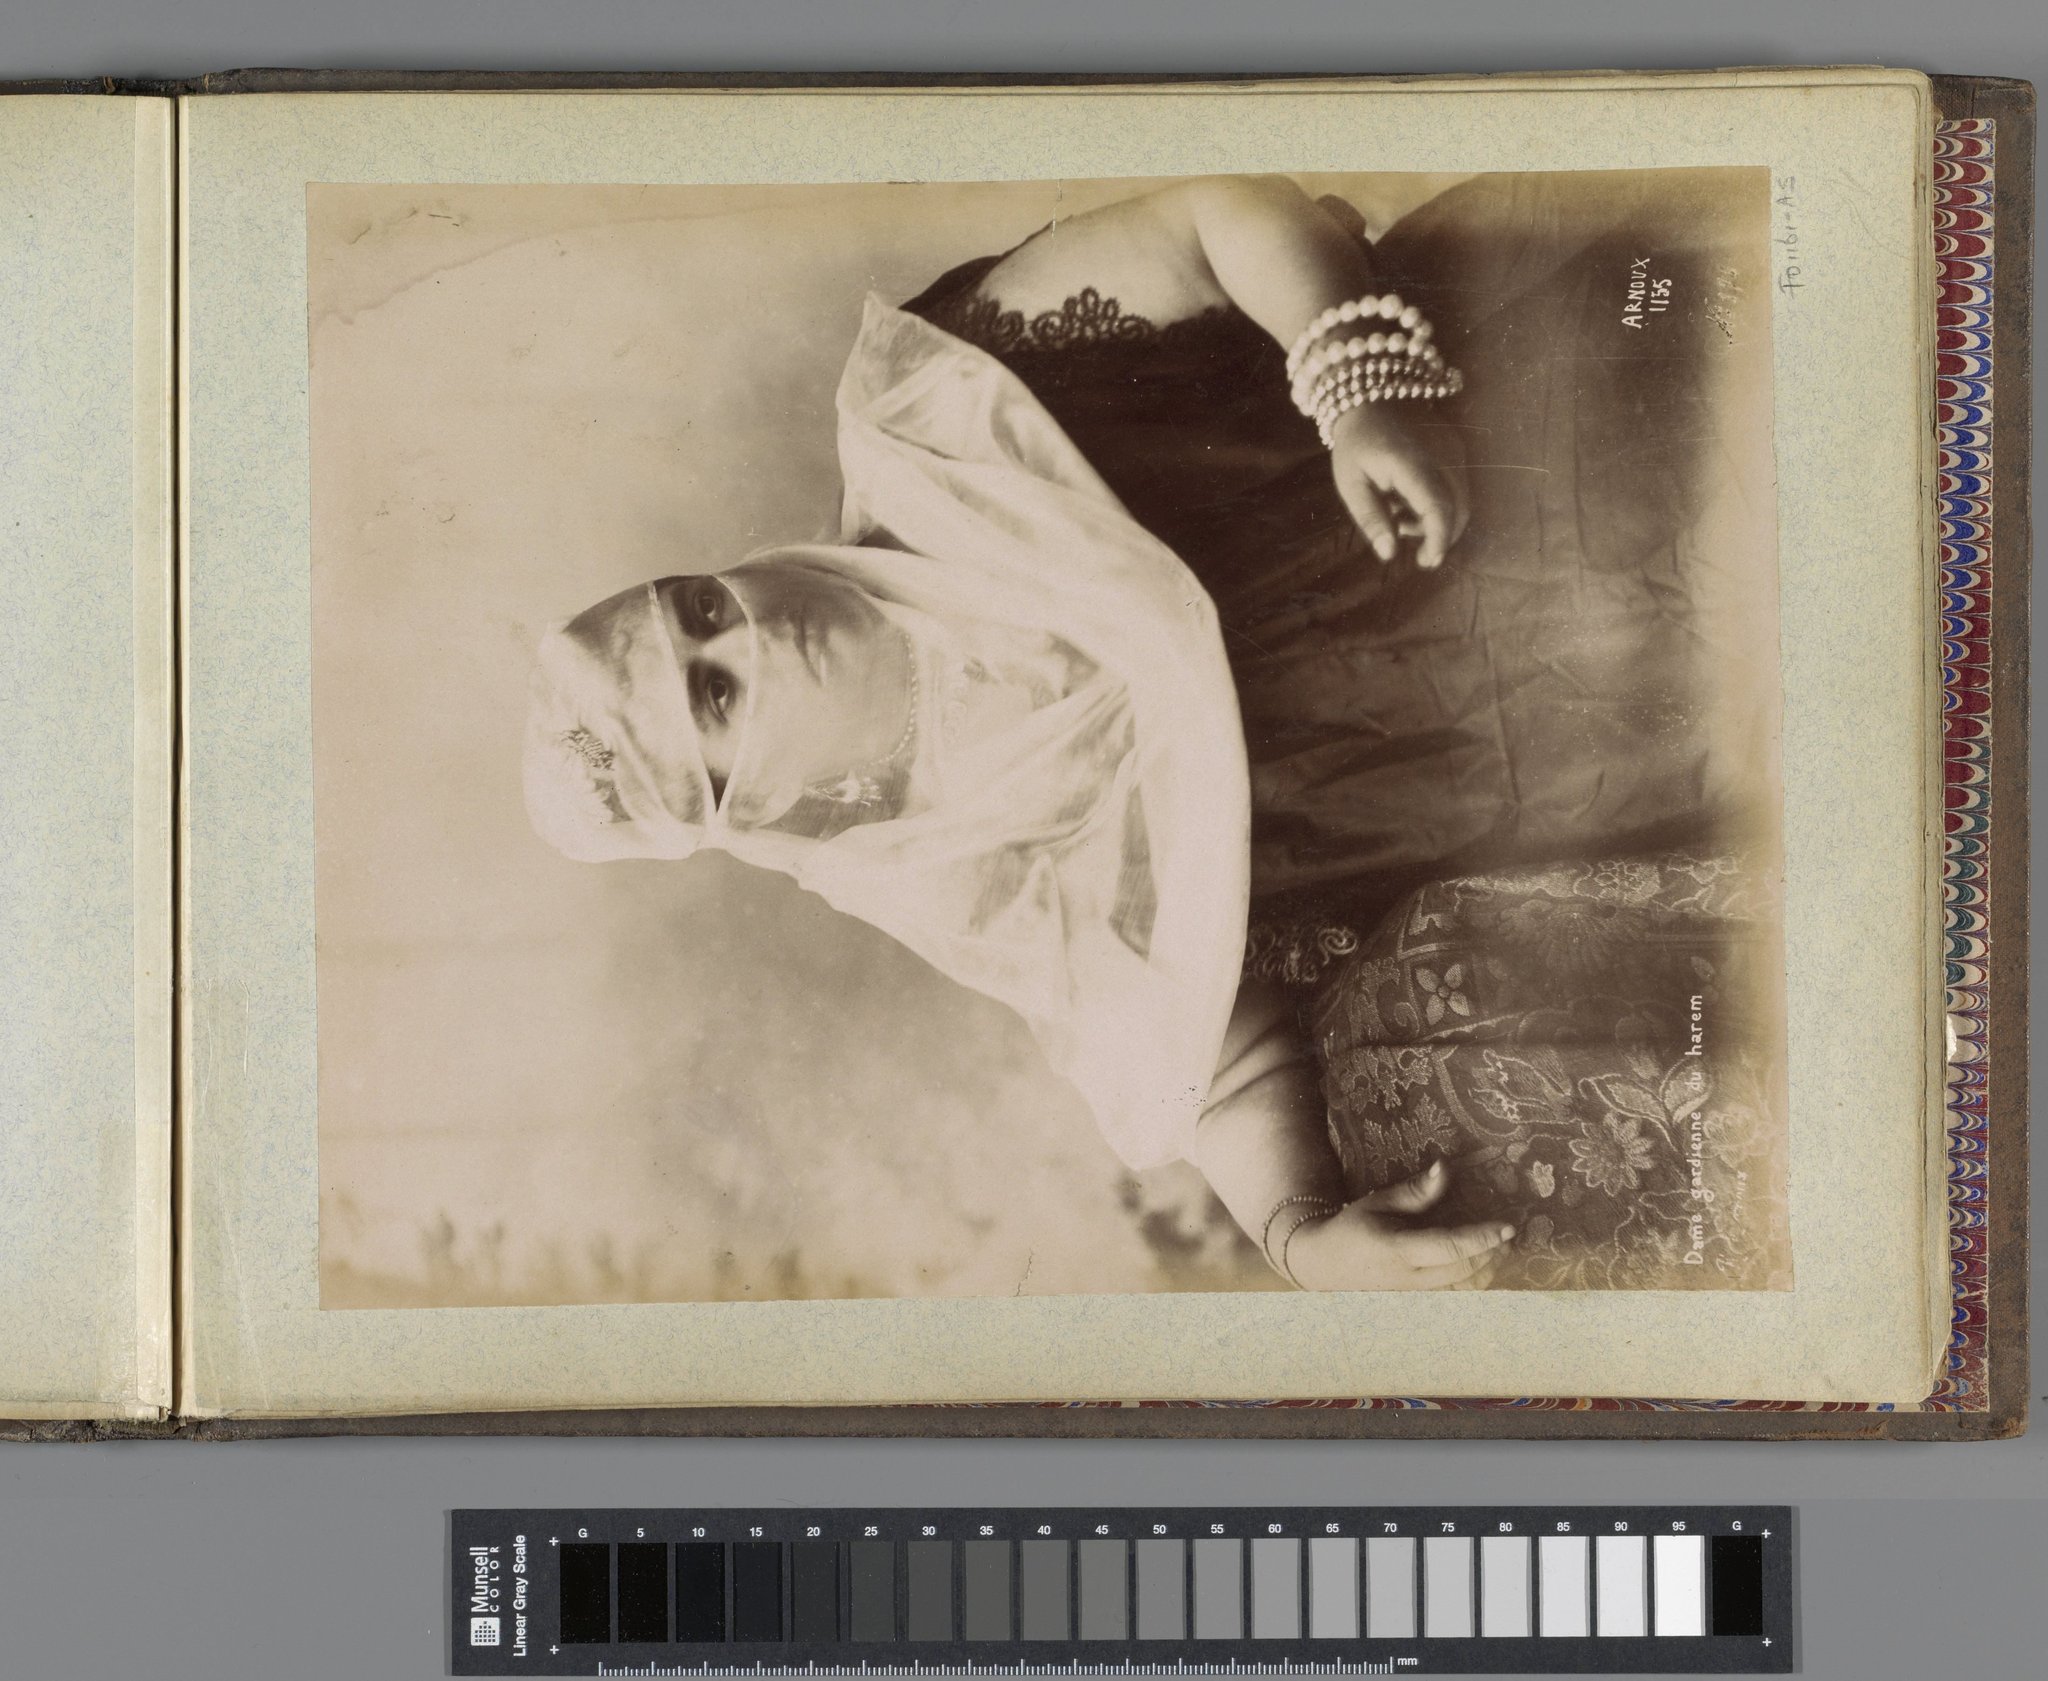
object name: photograph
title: Portret van een gesluierde harembewaakster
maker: hippolyte arnoux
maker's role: publisher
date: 1870-1891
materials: paper, photographic support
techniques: albumen print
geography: middle east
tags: guardian, adult woman, veil, harem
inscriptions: negative number: ‘1135’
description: Onderdeel van Fotoalbum van een reis naar Manilla.